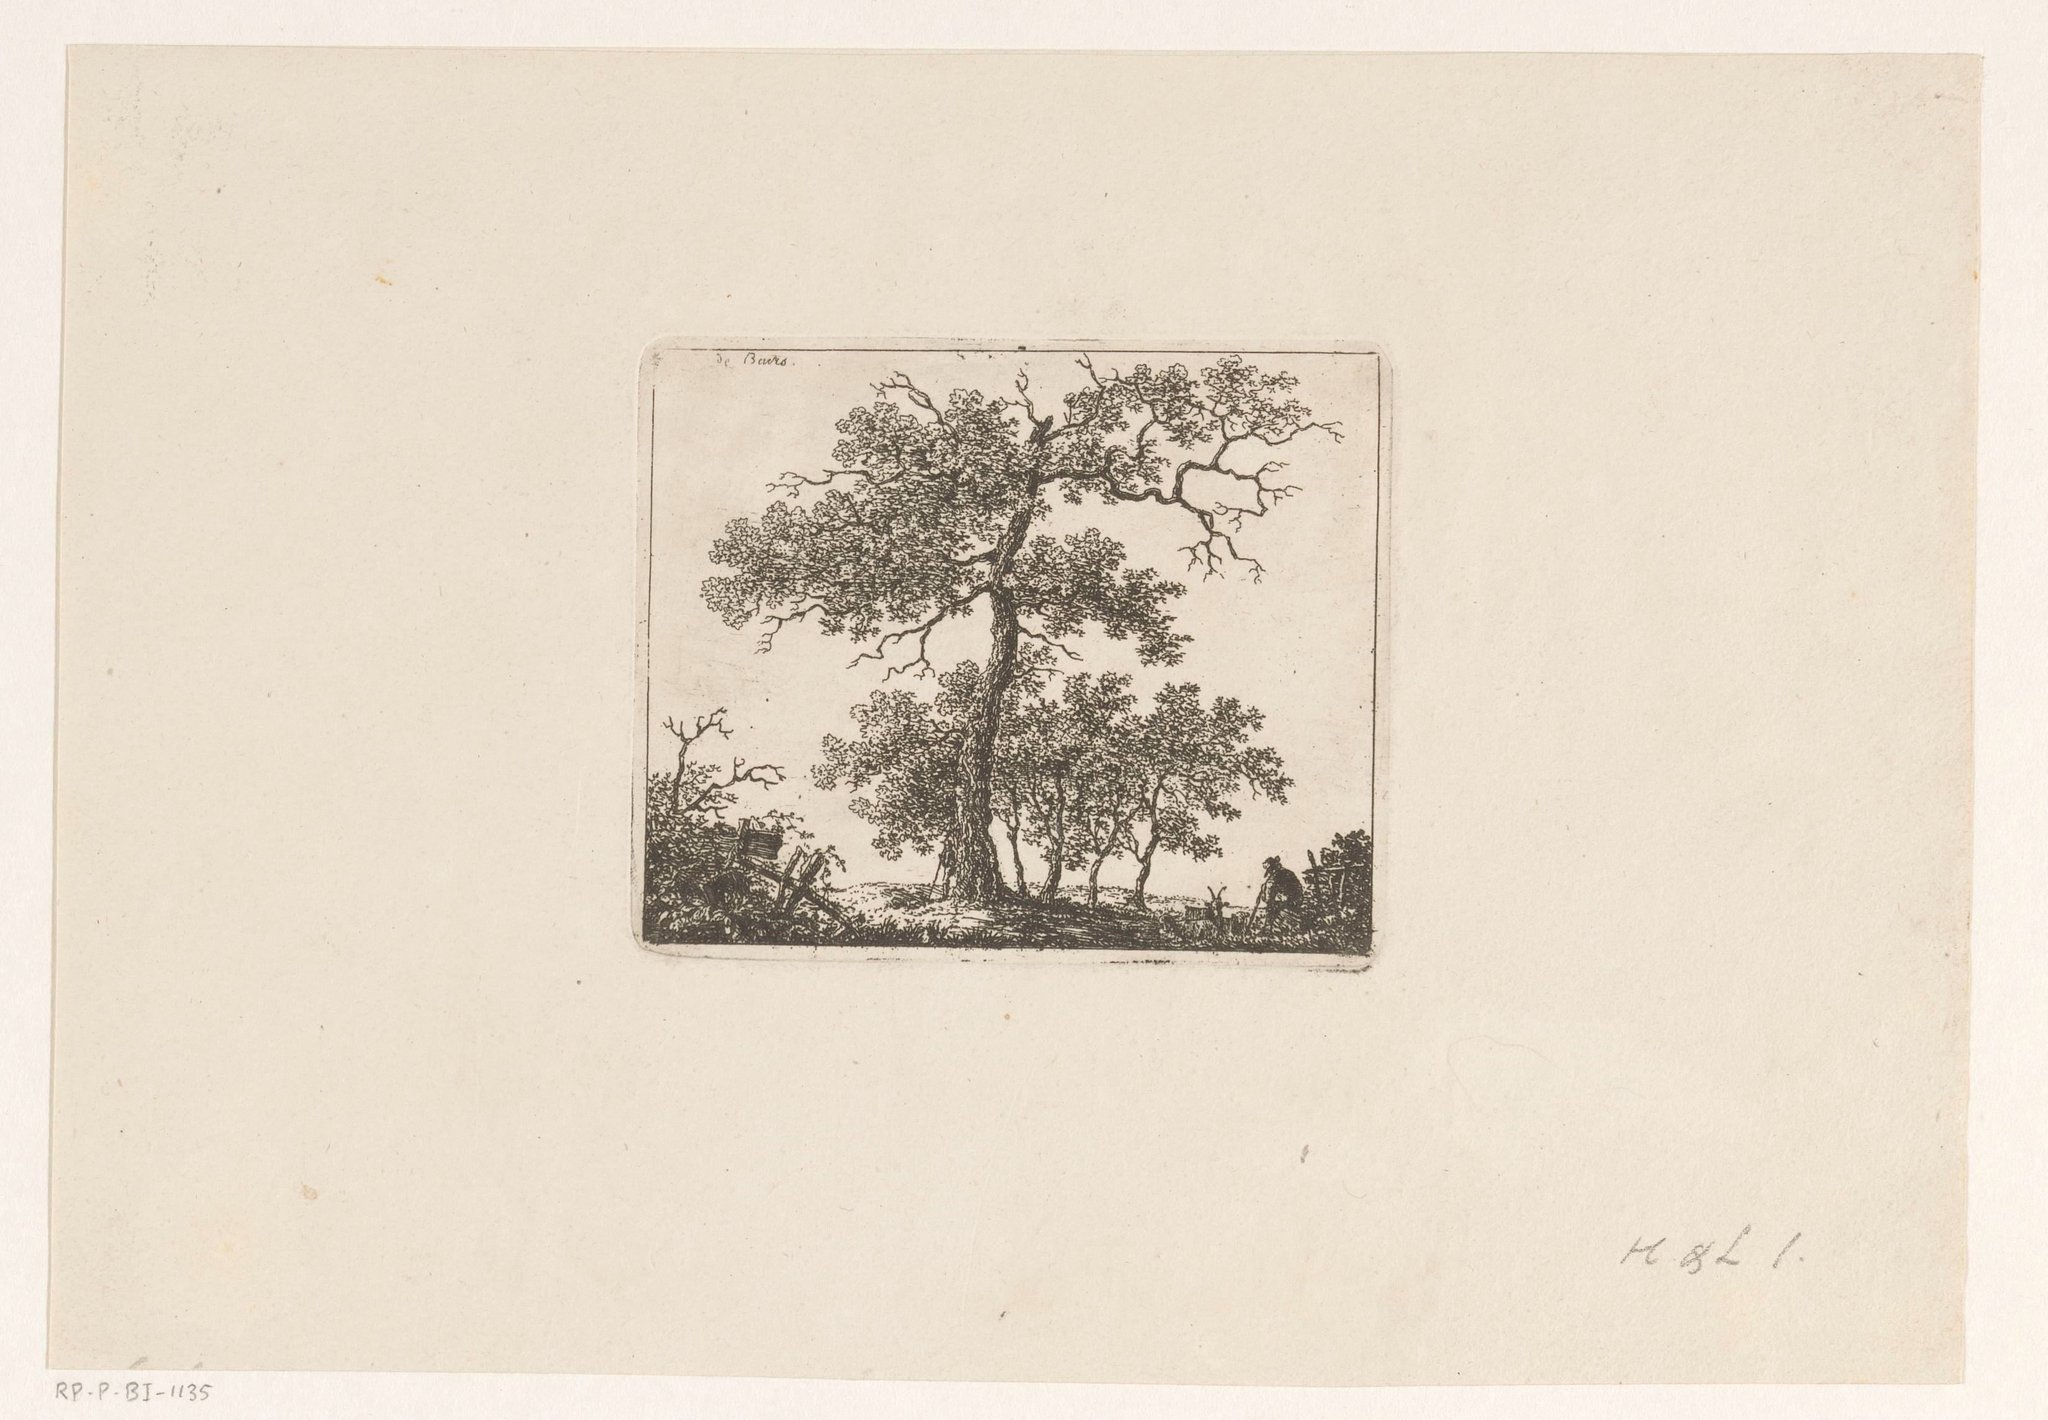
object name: print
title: Boom met een afgebroken top, een herder rechts op de voorgrond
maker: andré paul de beurs-stiermans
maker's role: print maker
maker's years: 1802-1832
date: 1812-1832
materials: paper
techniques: etching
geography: hamburg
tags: landscapes, herding, herdsman, herdswoman, shepherd, shepherdess, cowherd, etc.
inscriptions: collector's mark: Lugt 2228